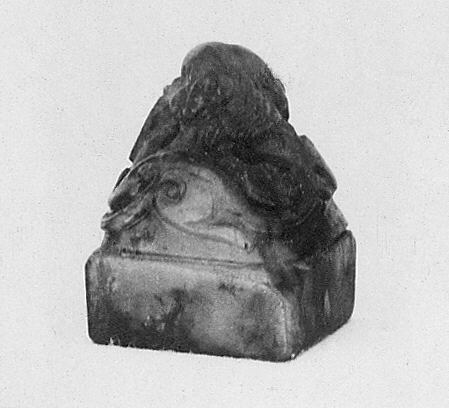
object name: seal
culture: chinese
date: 206 BCE-220 CE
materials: jade